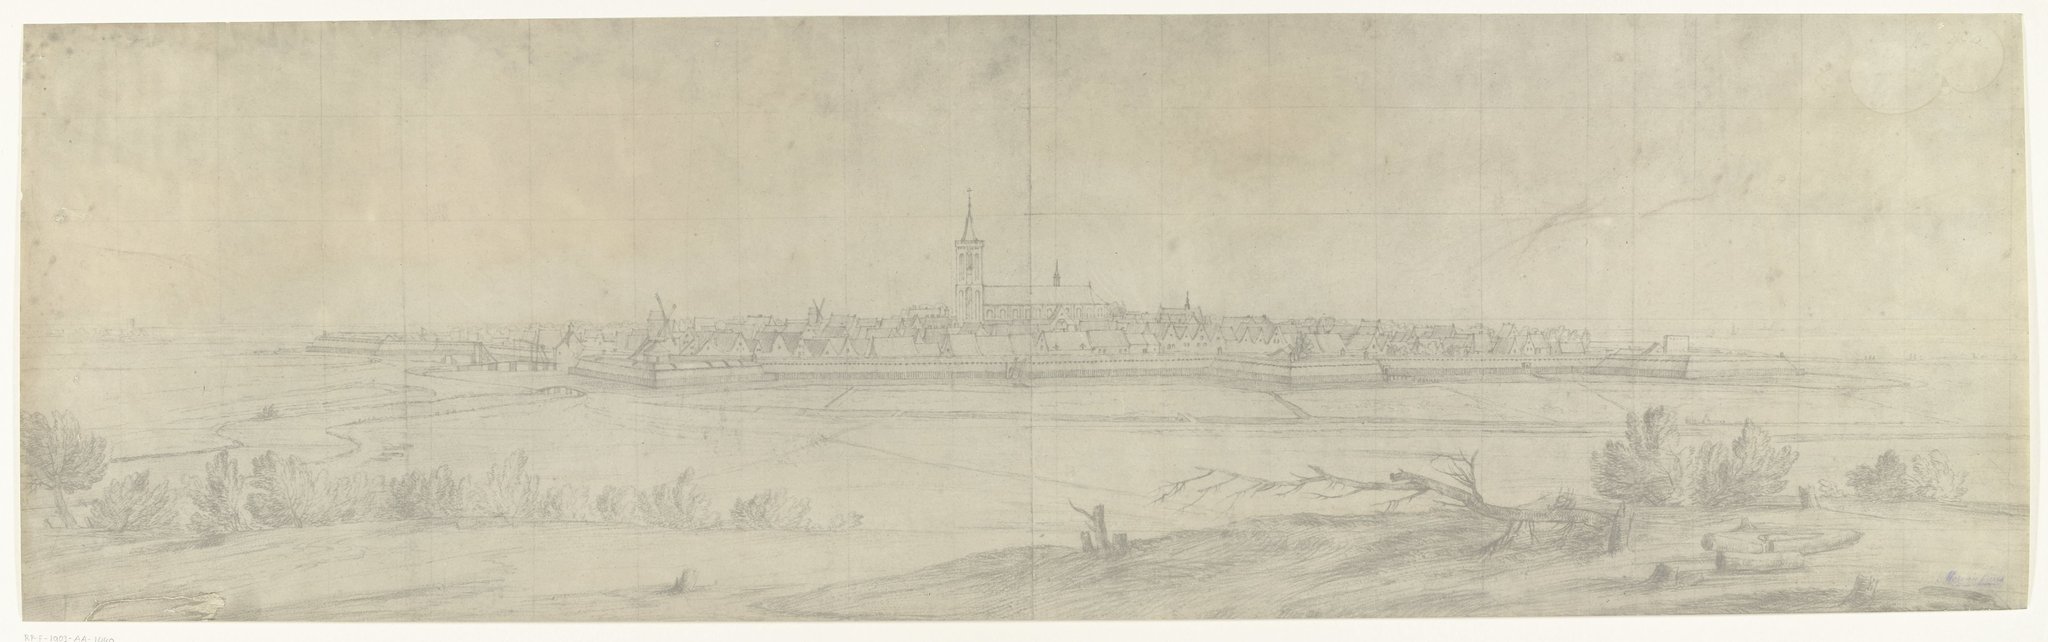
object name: photograph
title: Gezicht op Naarden, 1672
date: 1900-1903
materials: paper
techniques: gelatin silver print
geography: france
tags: lodewijk xiv (koning van frankrijk), prospect of city, town panorama, silhouette of city, rampjaar (disaster year)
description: Niet in Frederik Muller; door het RPK toegevoegd nummer. Onderdeel van een groep van ca. 50 foto's van tekeningen van de Franse inval in de Nederlanden in 1672 door Adam Frans van der Meulen, bewaard in de Manufacture Nationale des Gobelins te Parijs.